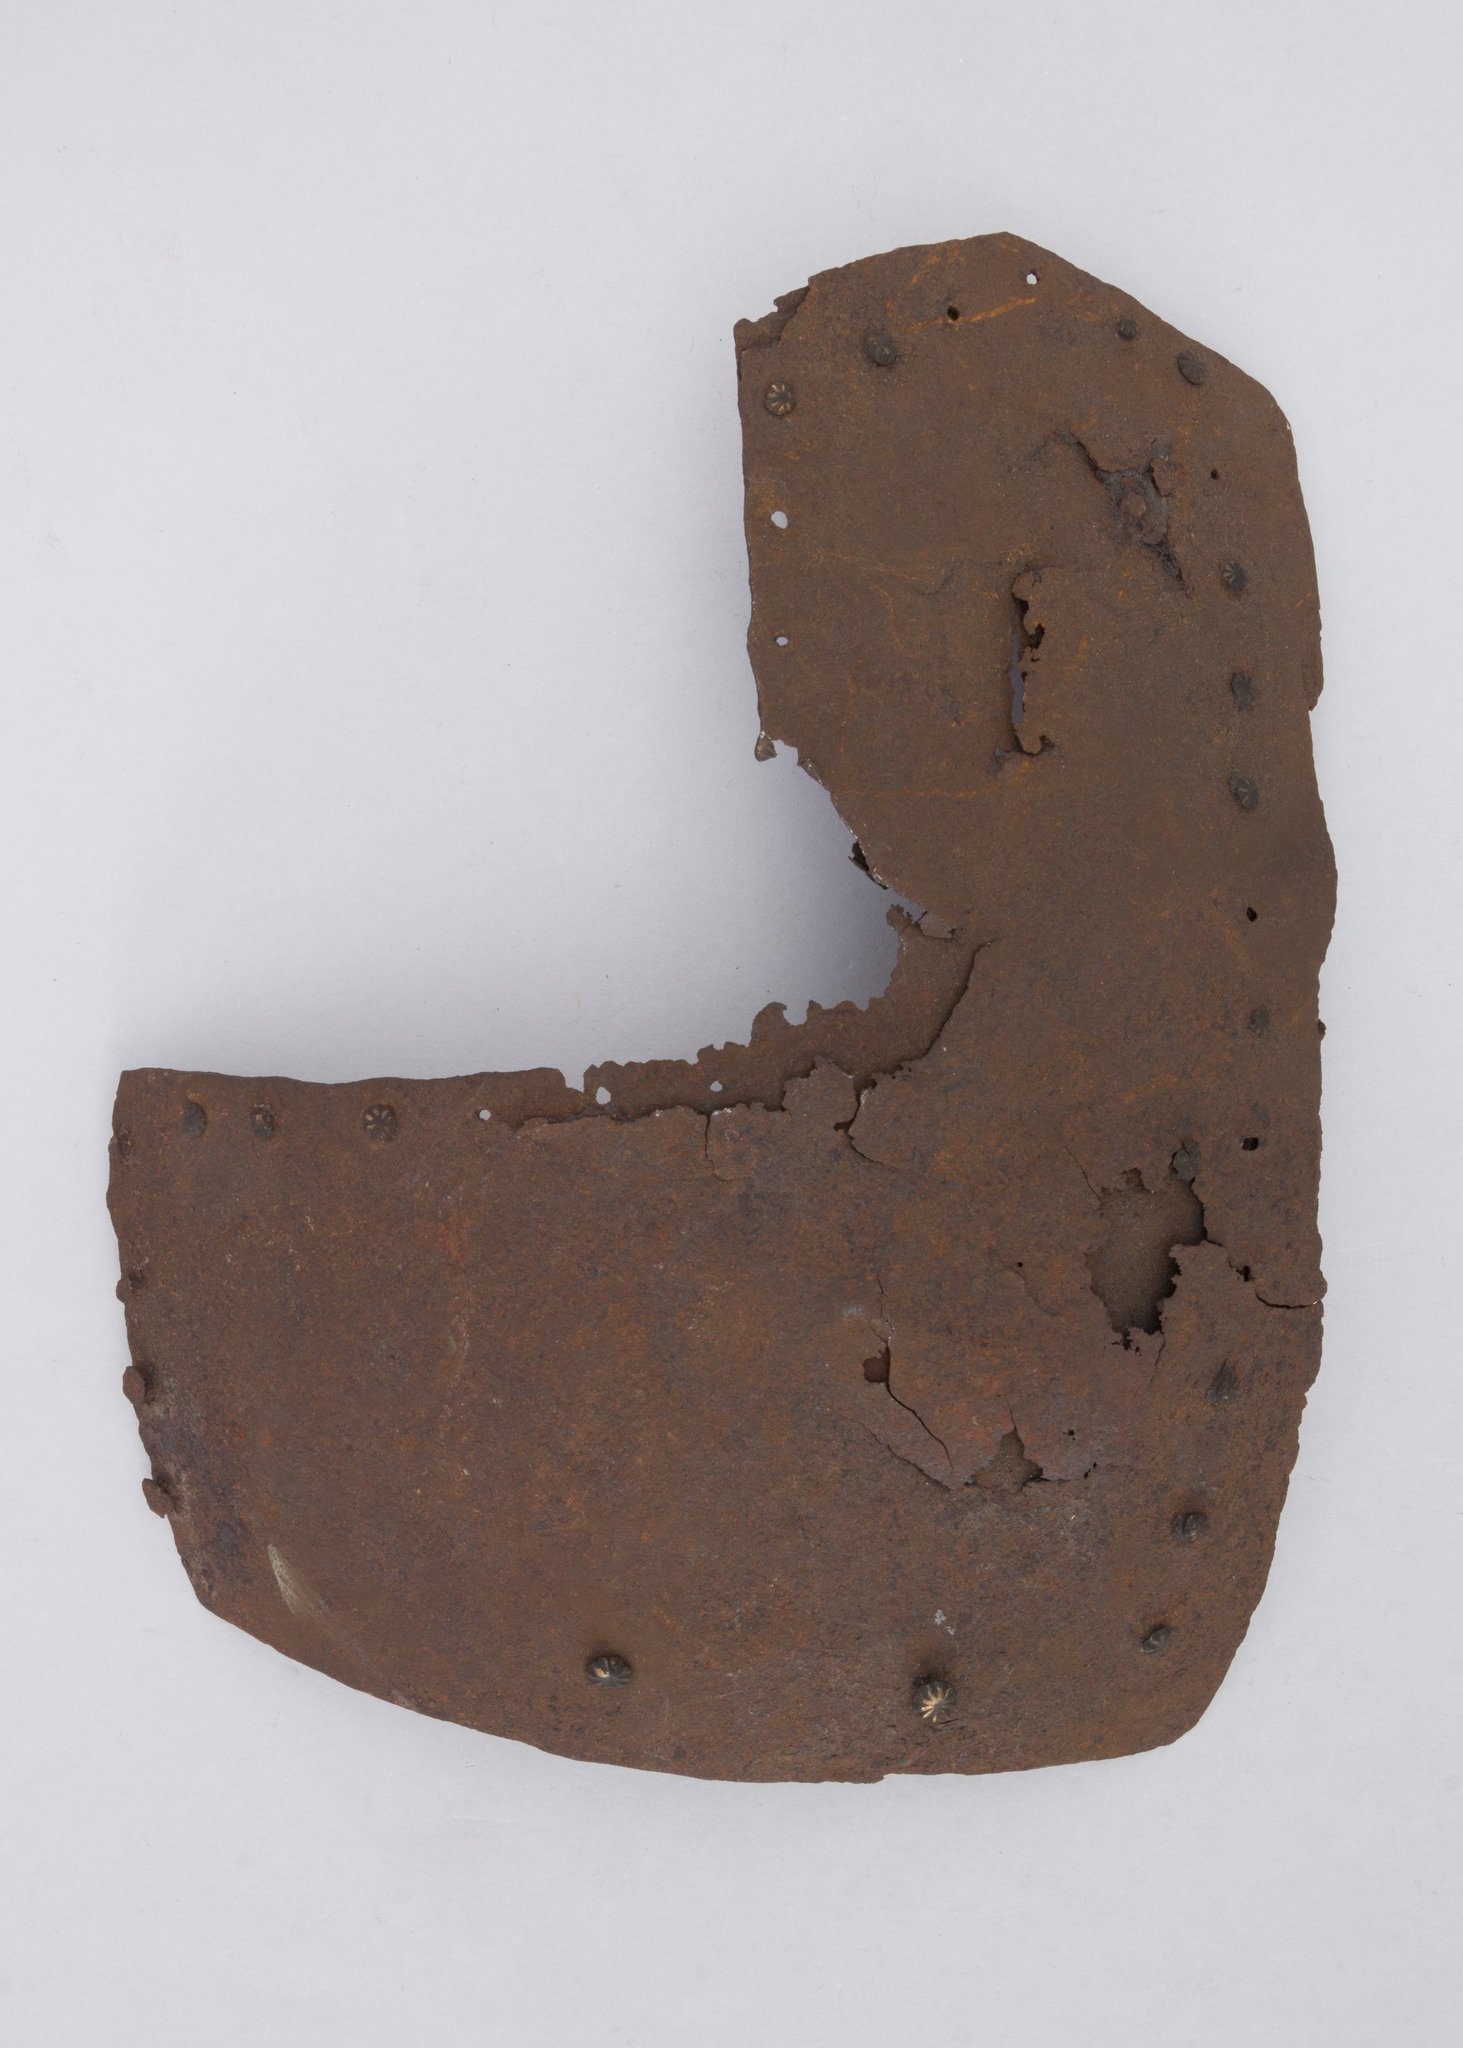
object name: brigandine plate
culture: italian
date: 1400-1450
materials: metal alloy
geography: italy